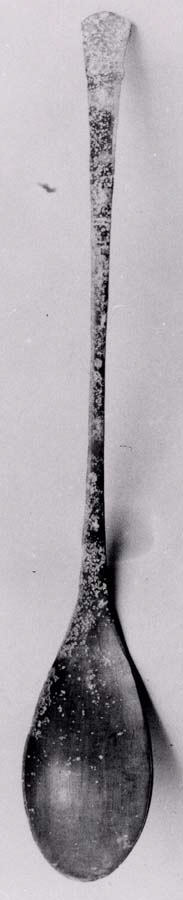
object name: spoon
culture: korean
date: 918-1392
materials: bronze